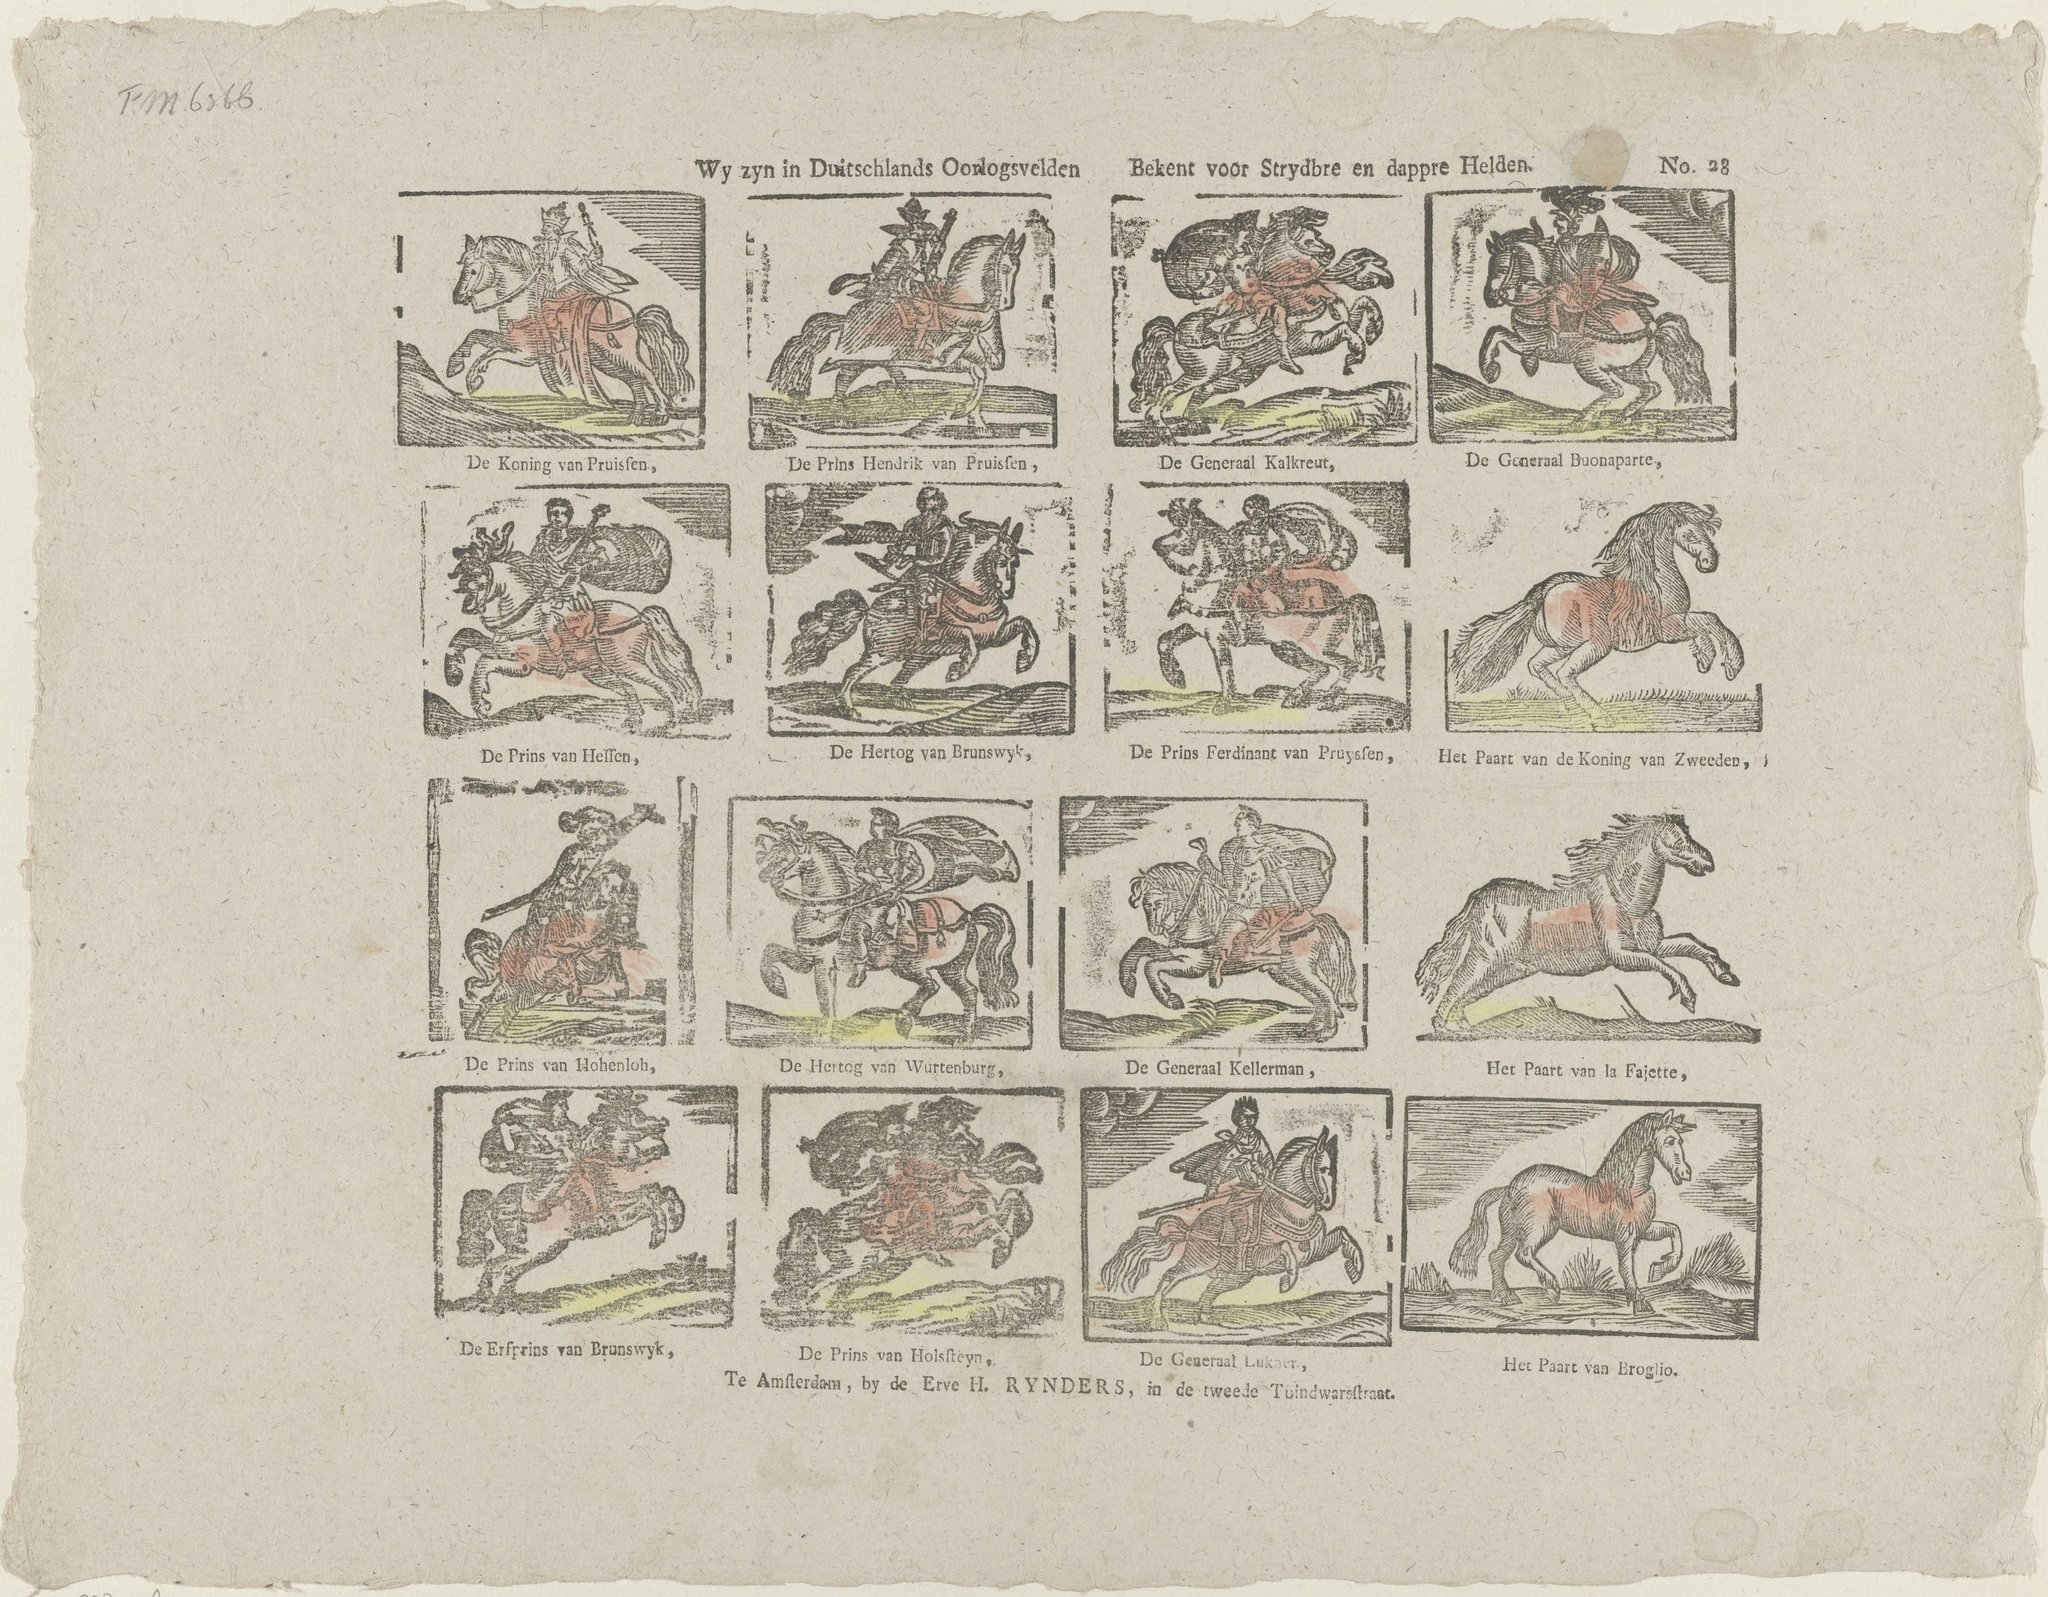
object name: popular print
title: Wy zyn in Duitschlands oorlogsvelden / Bekent voor strydbre en dappre helden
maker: Anonymous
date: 1831-1854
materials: paper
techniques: colour, letterpress printing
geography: netherlands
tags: equestrian state-portrait, warfare; military affairs (+ cavalry, horsemen), horse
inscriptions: collector's mark: Lugt 2228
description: Blad met 16 voorstellingen van paarden en heersers en militairen te paard. Onder elke afbeelding een onderschrift. Genummerd rechtsboven: No. 28